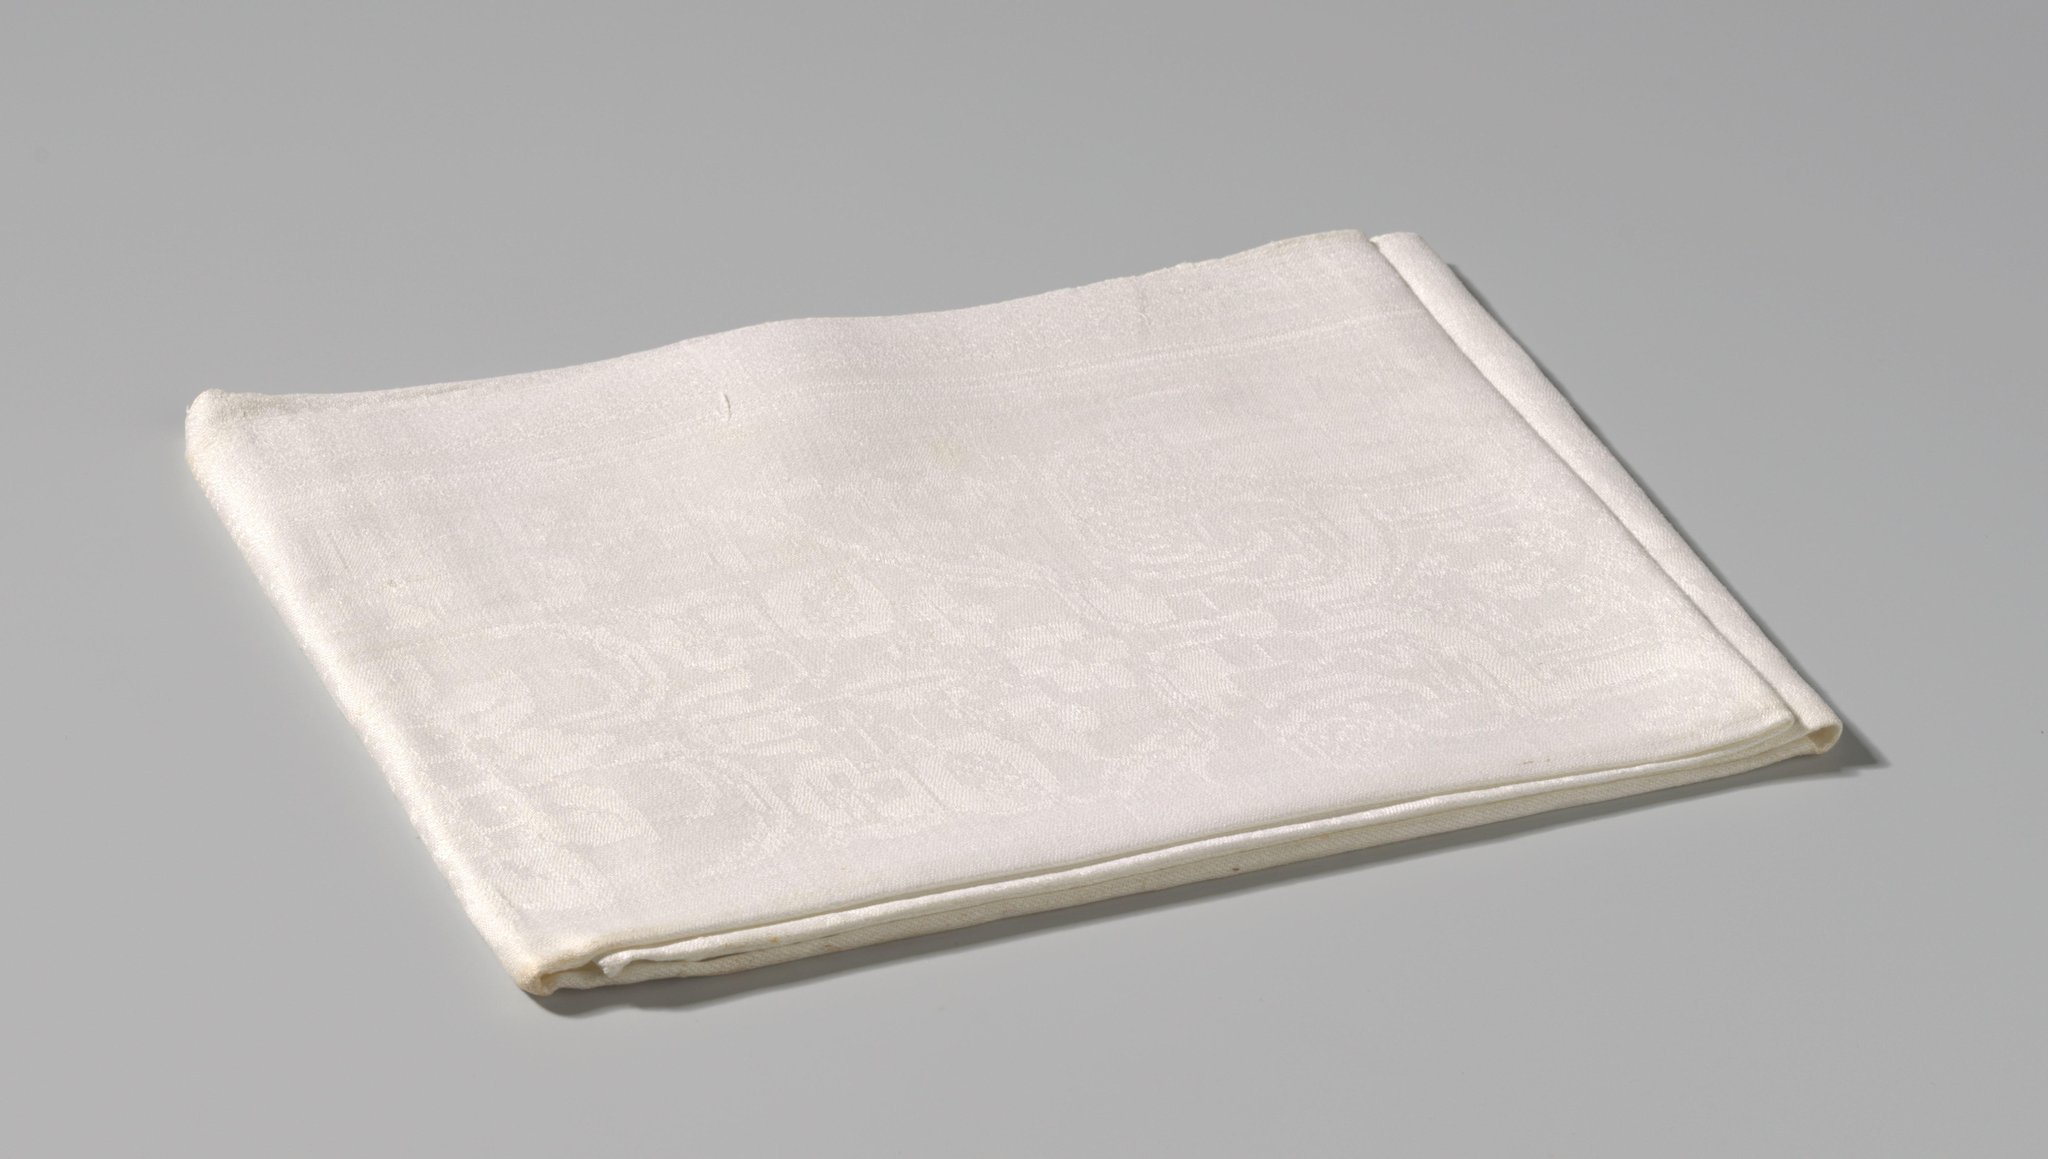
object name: napkin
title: Servet van linnendamast met een bloempatroon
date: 1725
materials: linen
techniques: damask, weave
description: Servet van linnendamast met bloemen en een regence-ornament. Het servet hoort bij negen servetten (BK-1974-87-A t/m BK-1974-87-J) en een tafellaken (BK-1974-86).